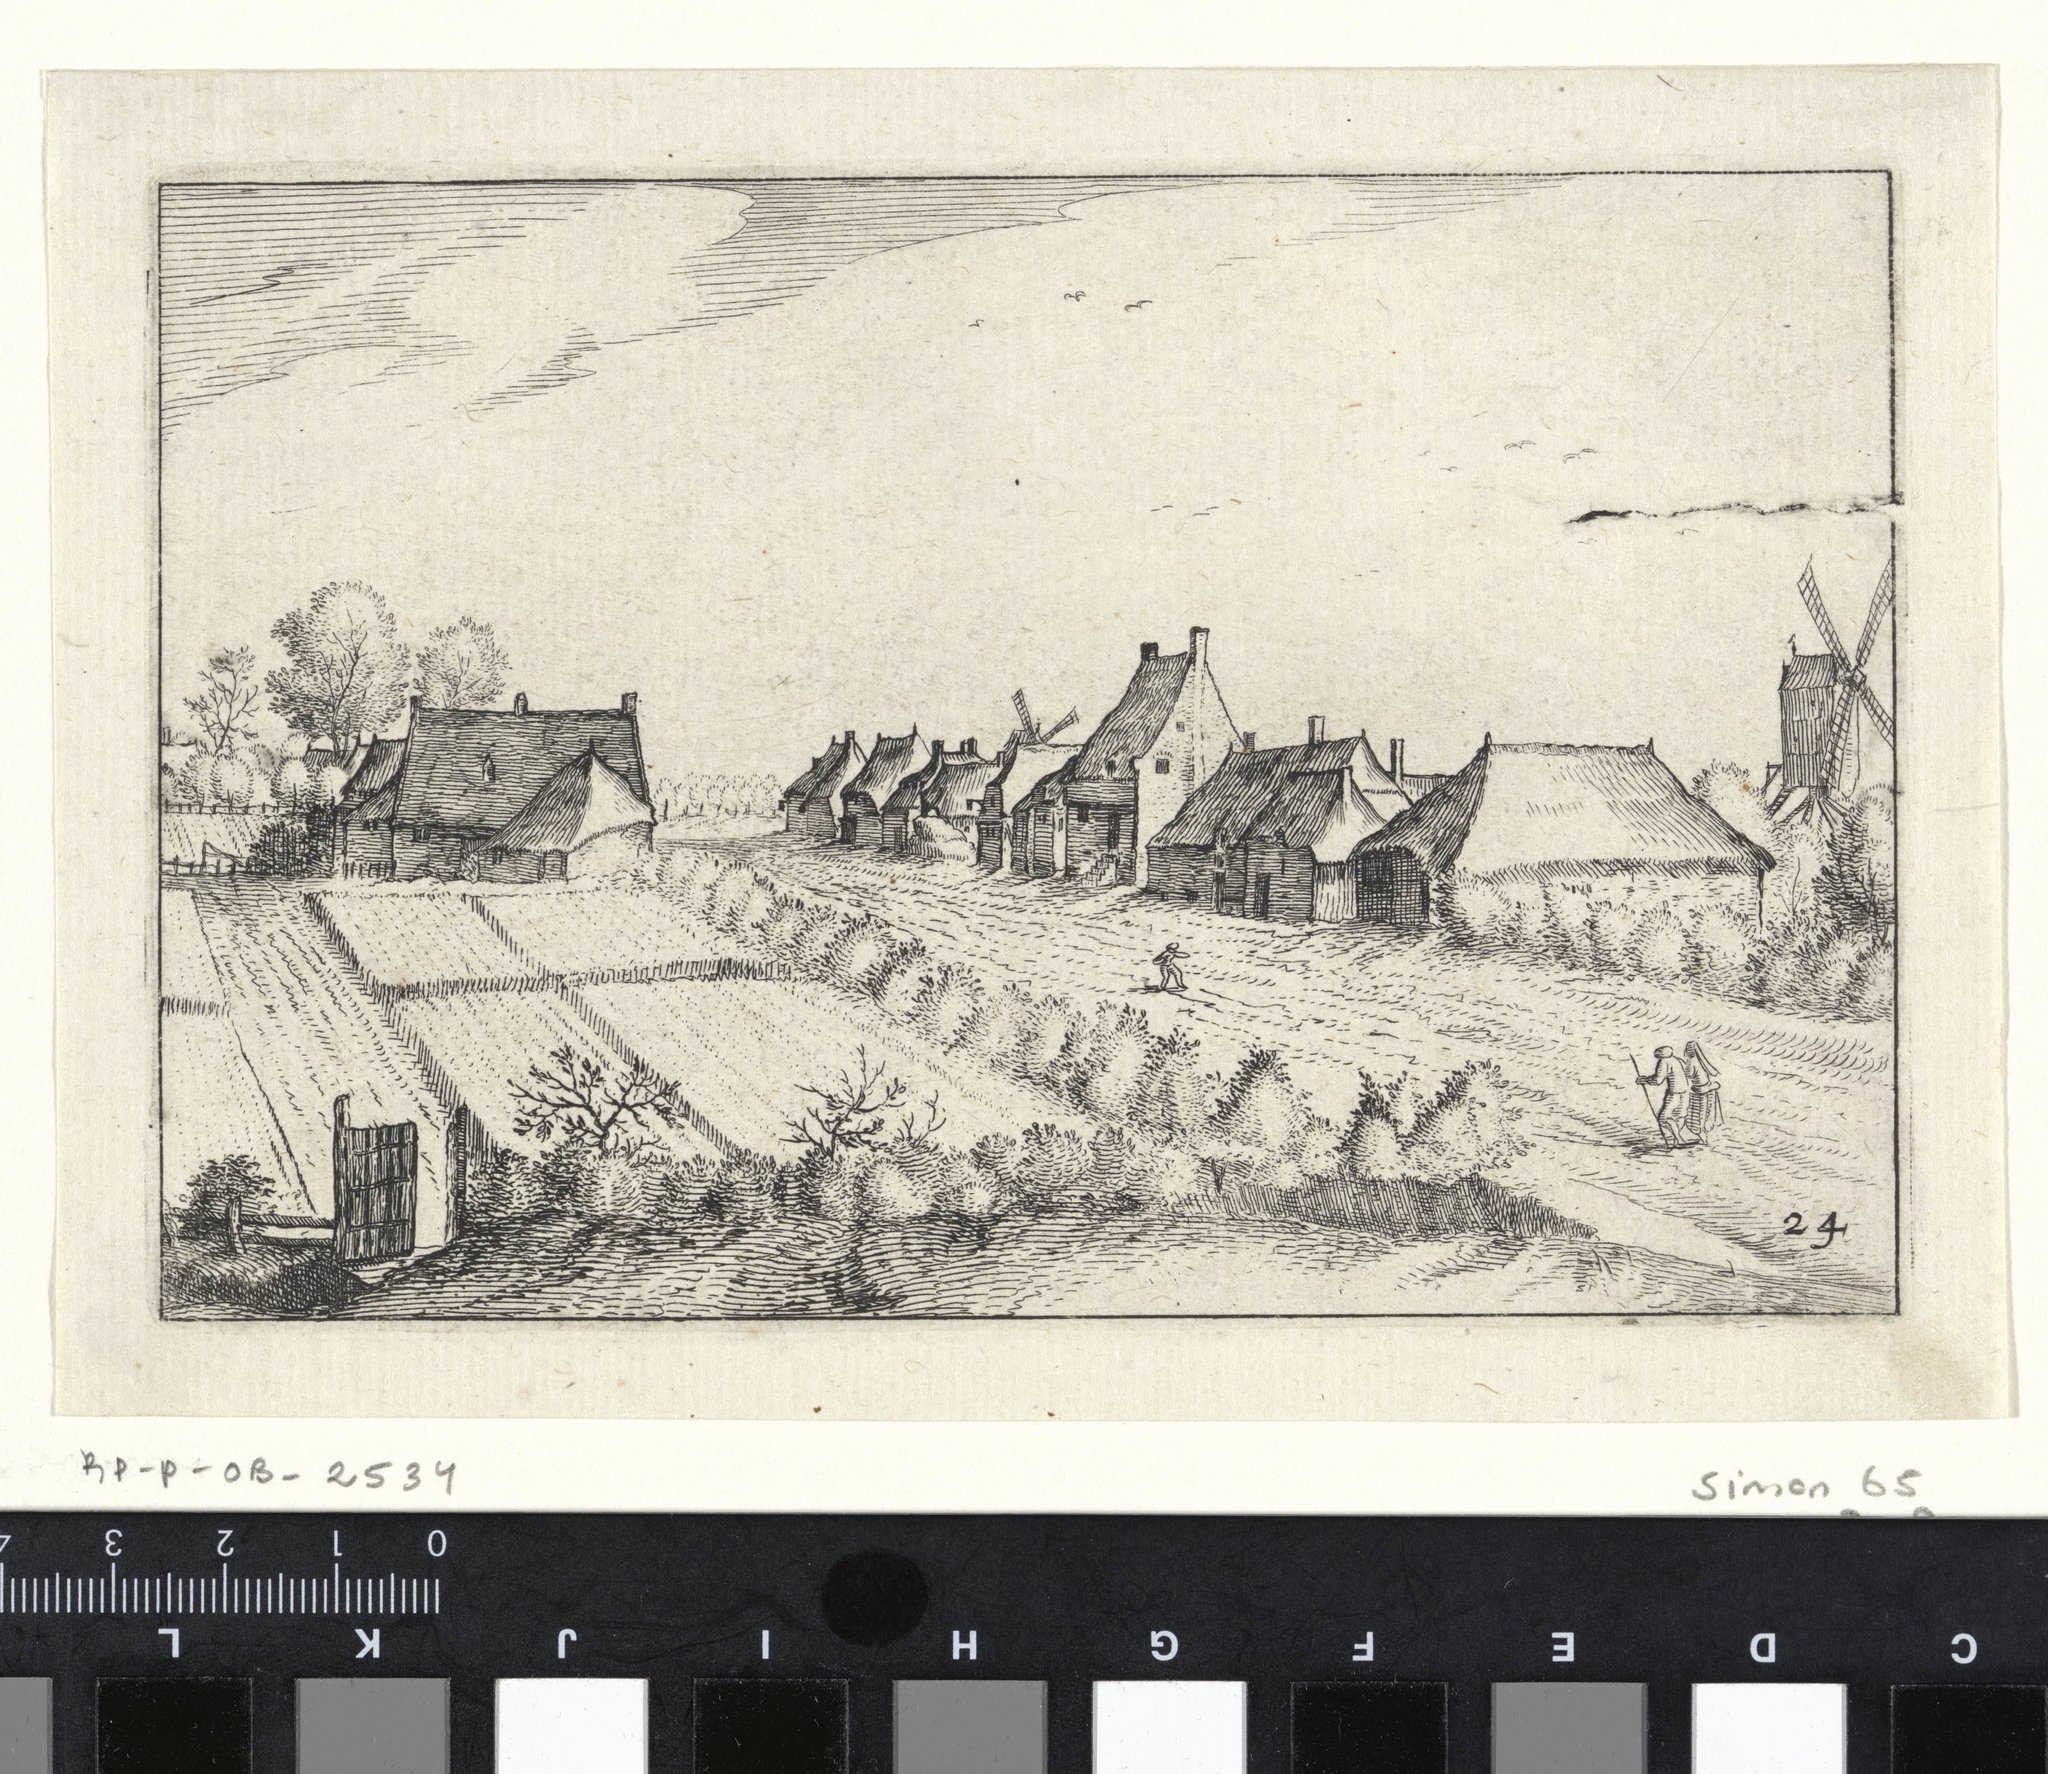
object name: print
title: Huizen aan een weg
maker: claes jansz. visscher (ii)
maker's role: draughtsman, print maker, publisher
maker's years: 1586-1652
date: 1620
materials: paper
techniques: etching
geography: amsterdam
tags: landscapes, windmill, street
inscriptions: collector's mark: Lugt 240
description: Gezicht op een vlak landschap met een weg met aan weerszijden huizen. Over de weg lopen enkele mensen en rechts staat een molen.